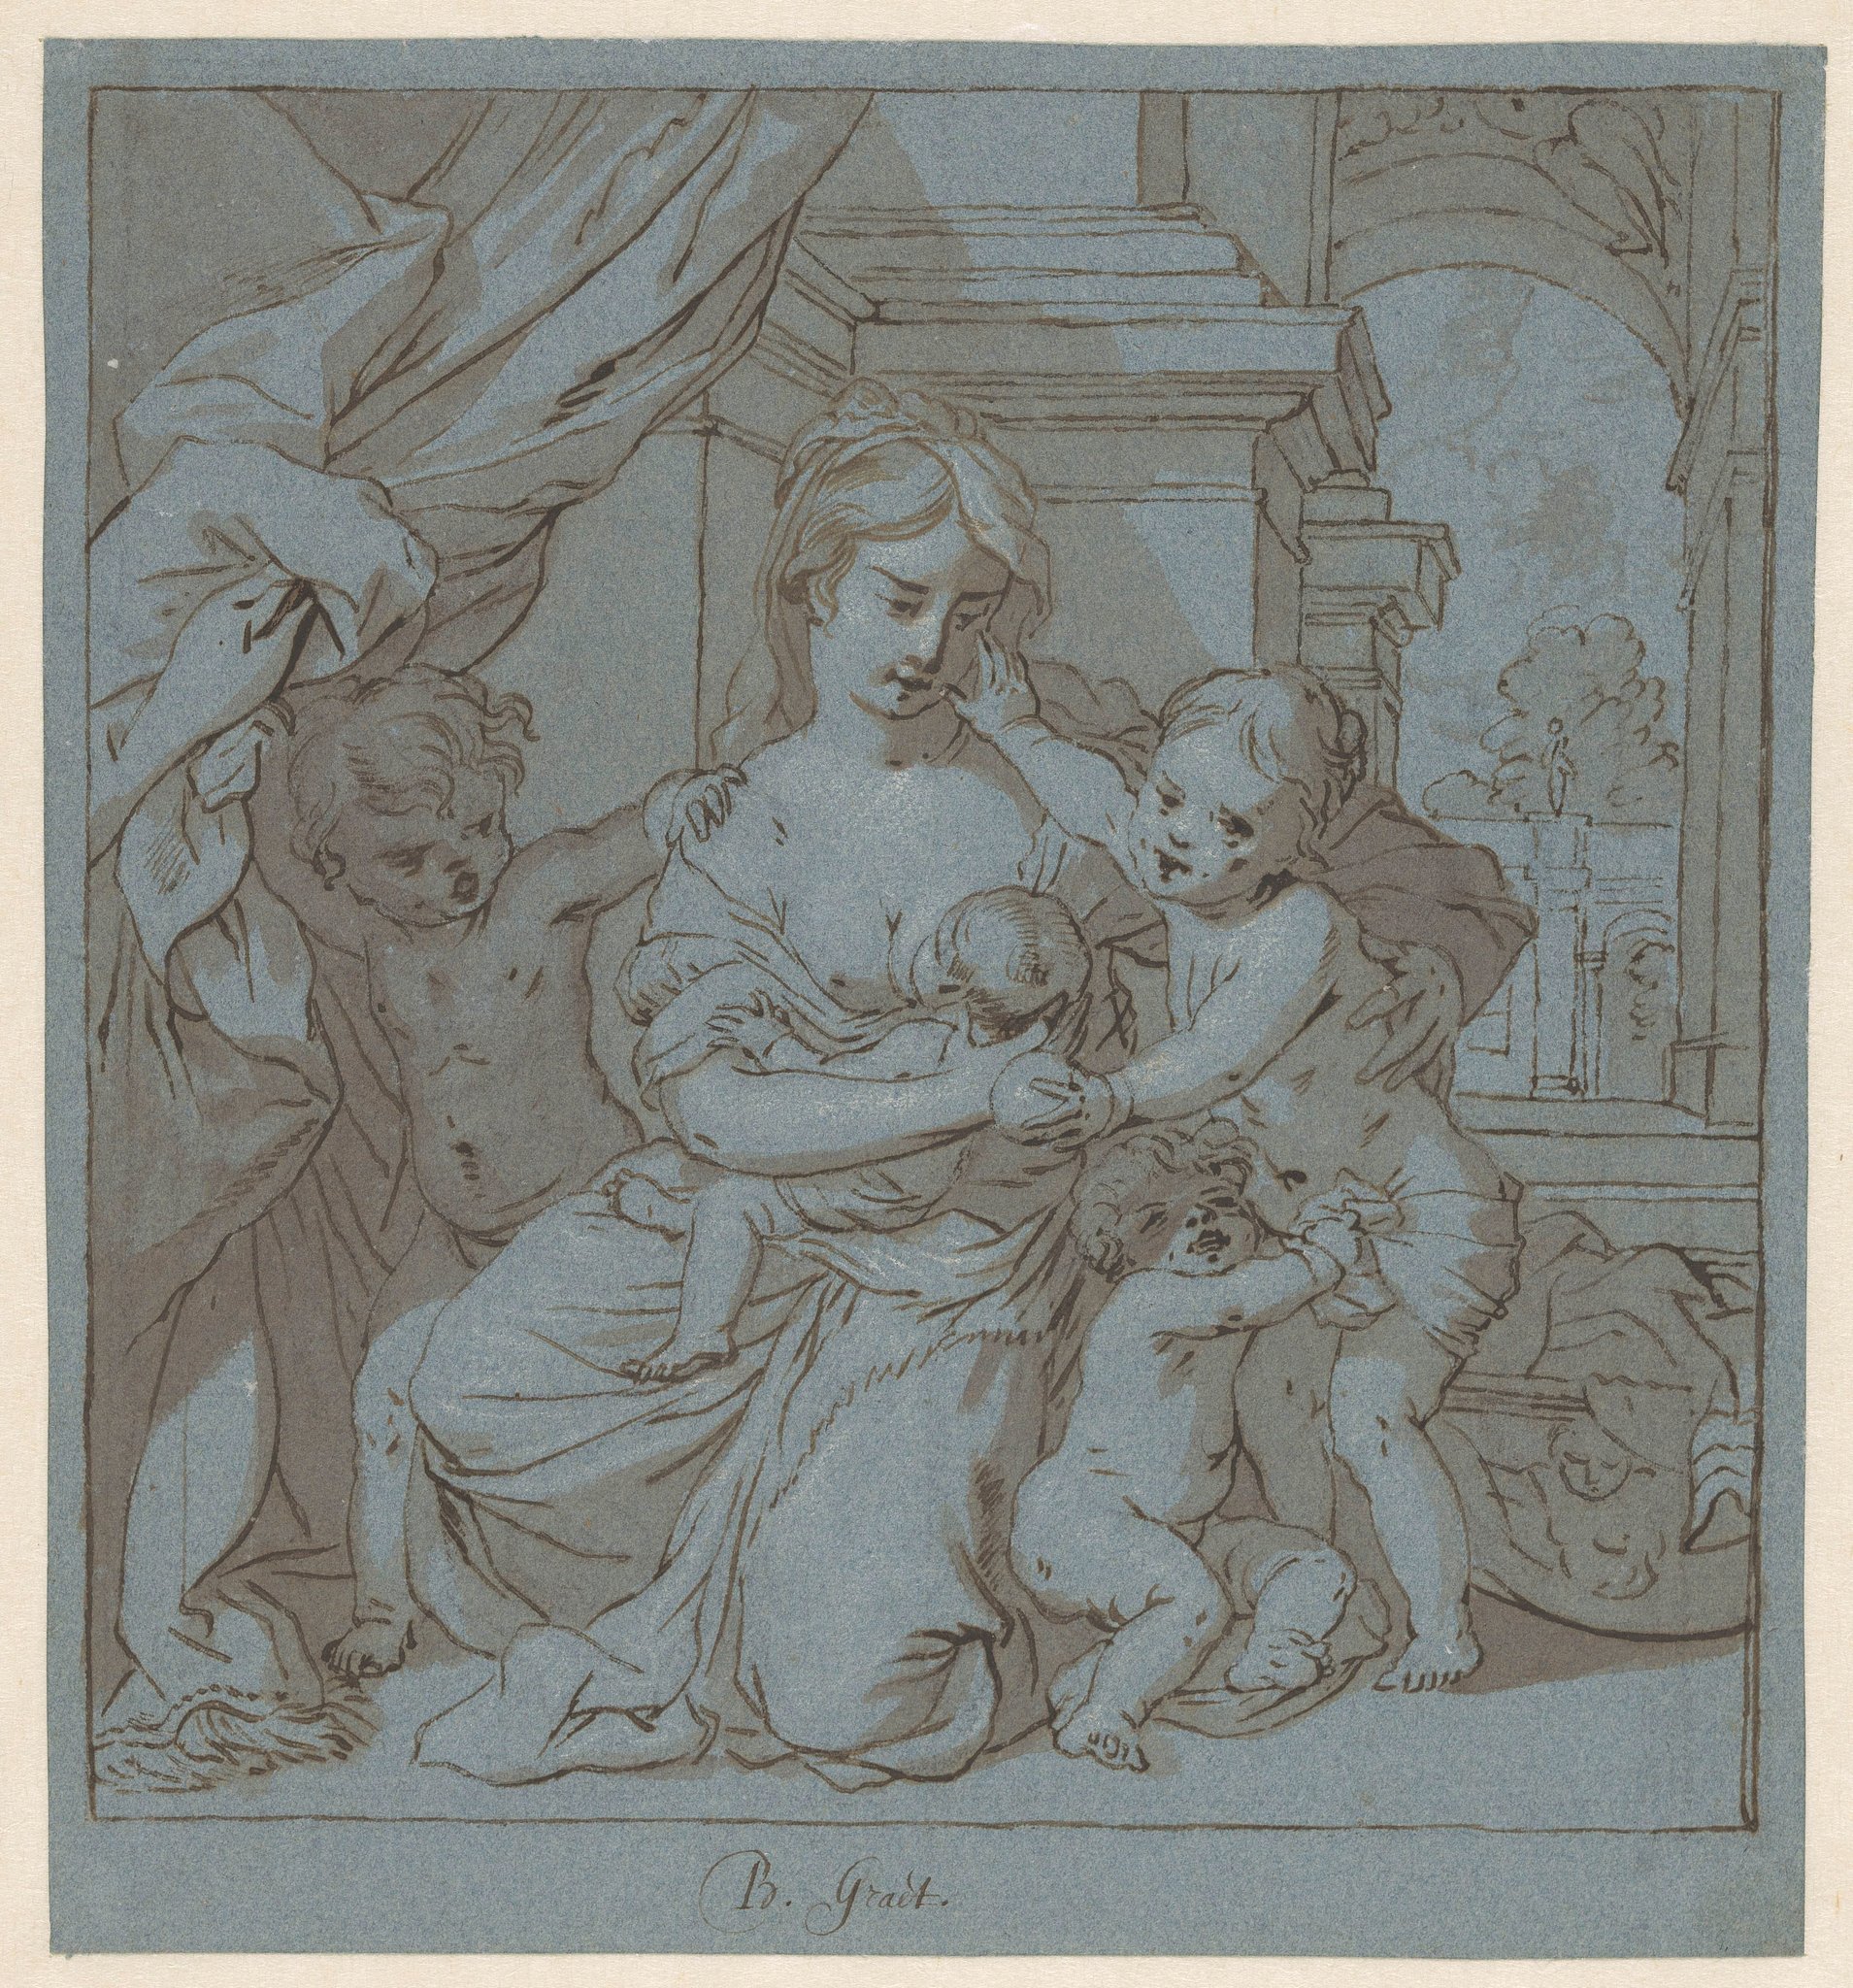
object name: drawing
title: Liefde (Charitas)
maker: barend graat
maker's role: draughtsman, print maker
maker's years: 1628-1709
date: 1638-1709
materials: ink, paper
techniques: brush, pen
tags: charity, 'caritas'; 'carità' (ripa) ~ one of the three theological virtues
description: Jonge vrouw met een kind aan de borst en om haar heen spelende kinderen.